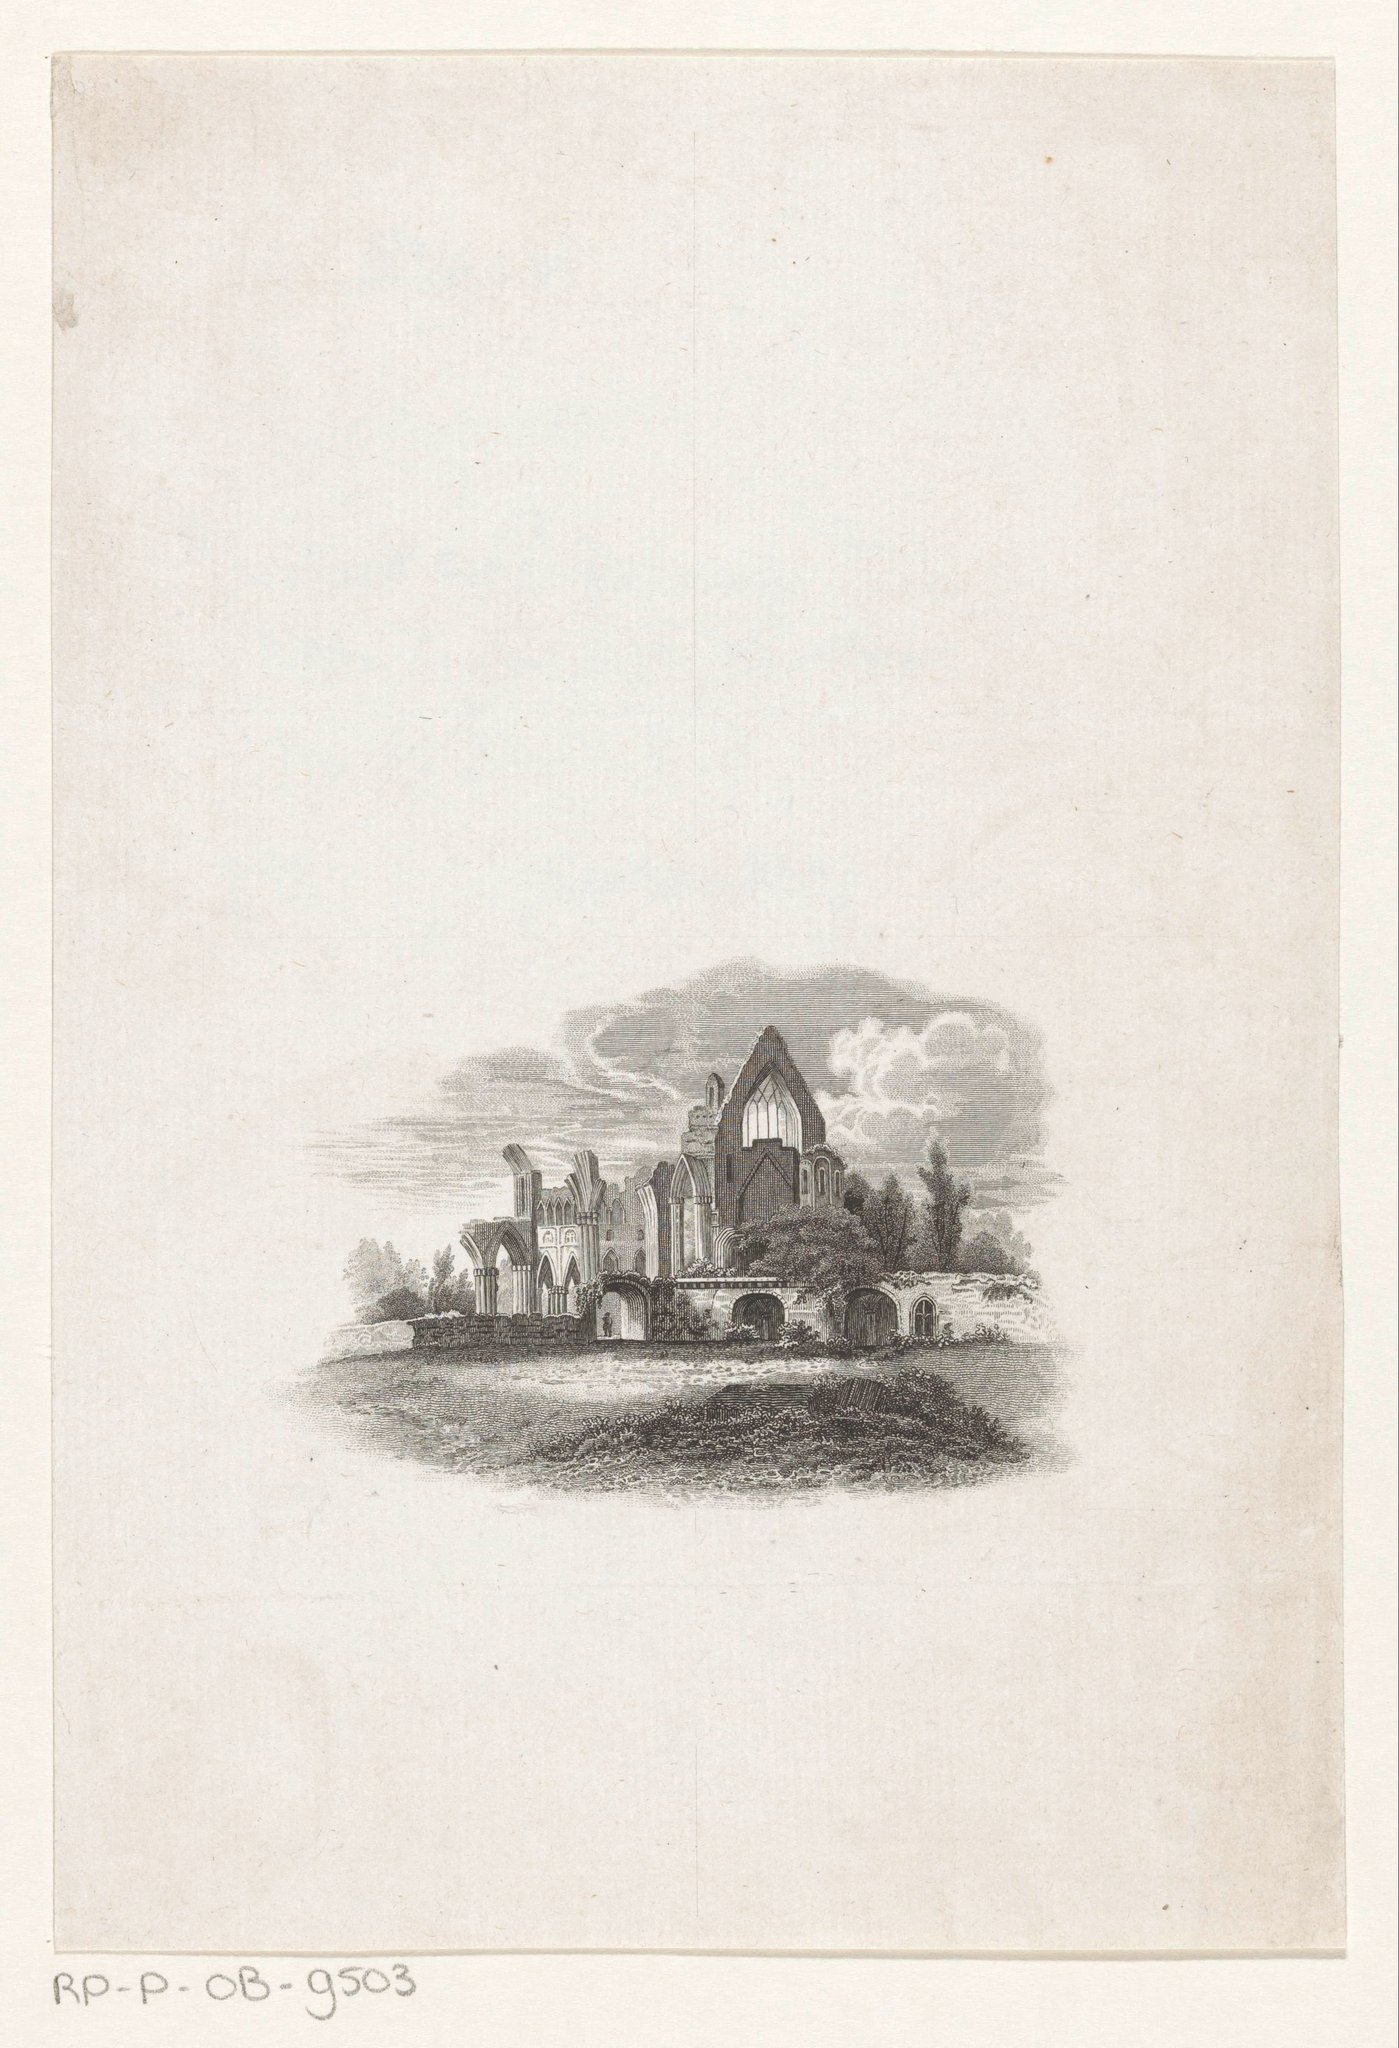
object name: titelblad, titelpagina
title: Titelpagina voor: A. Pichot, Geschied- en letterkundige reis naar Engeland en Schotland, 1827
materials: paper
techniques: engraving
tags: ruin of church, monastery, etc.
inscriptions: collector's mark: Lugt 2228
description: Proefdruk van titelpagina voor: Pichot, A. Geschied- en letterkundige reis naar Engeland en Schotland. Derde deel. Haarlem: Loosjes Pz., weduwe Adriaan, 1827.